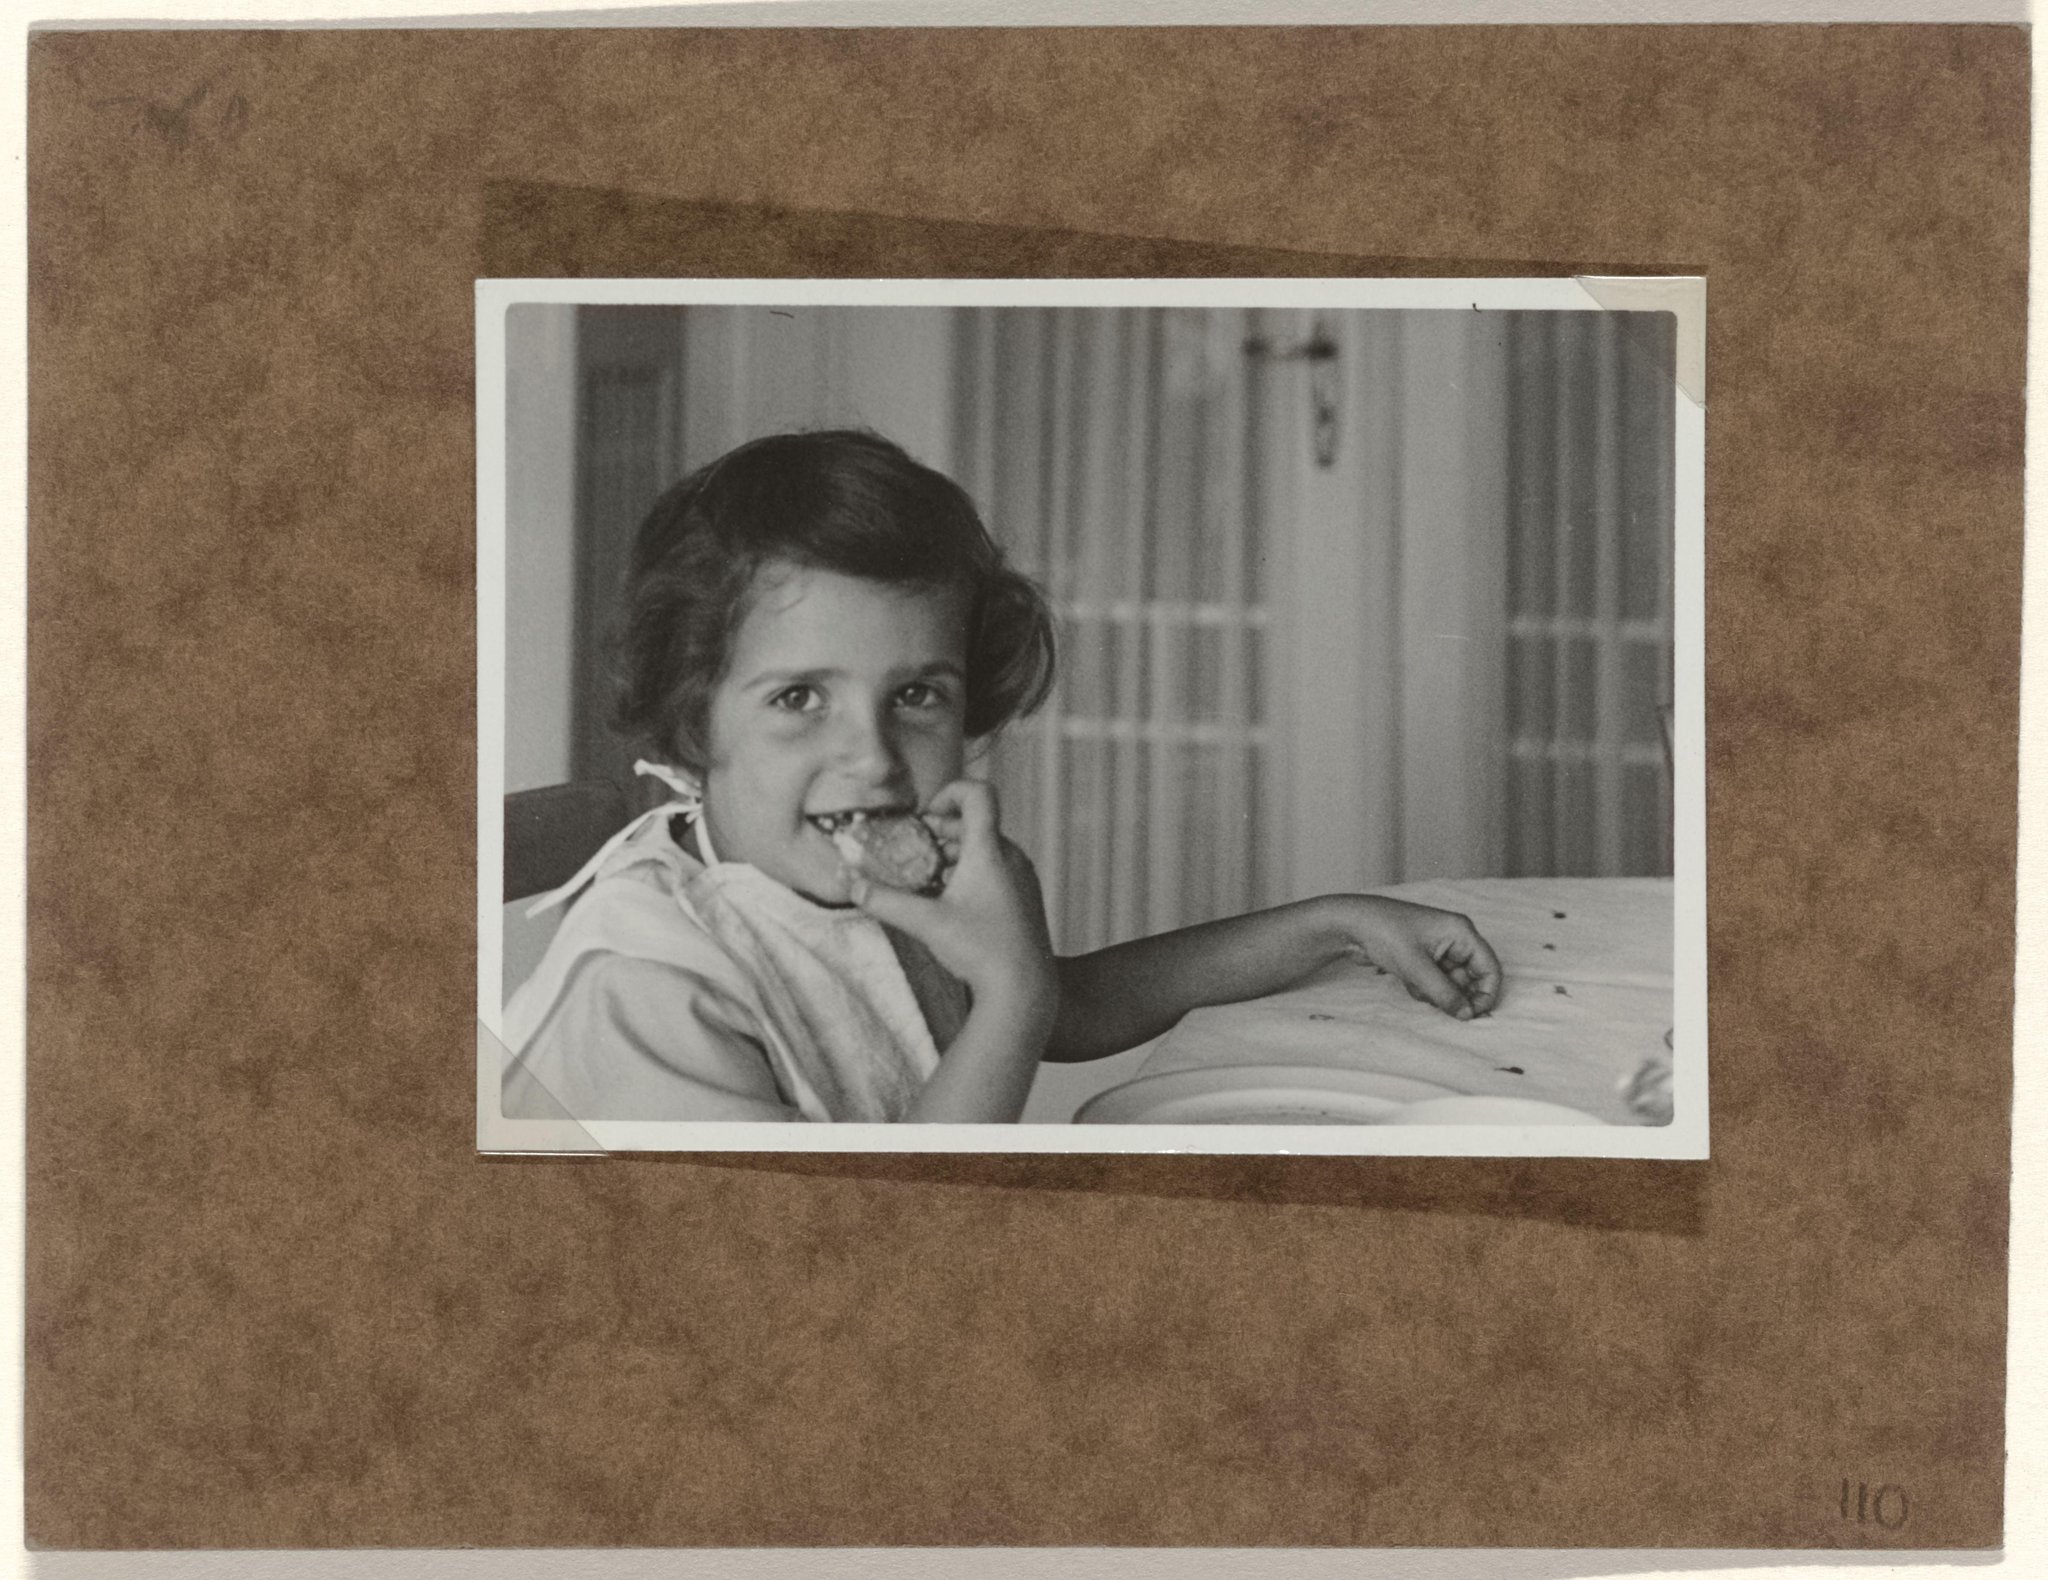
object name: photograph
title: Isabel Wachenheimer eet een koekje in de woning van de familie Wachenheimer in Stuttgart, 1931-1937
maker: Anonymous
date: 1931-1937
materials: photographic support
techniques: gelatin silver print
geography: stuttgart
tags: leiden, isabel wachenheimer-elon